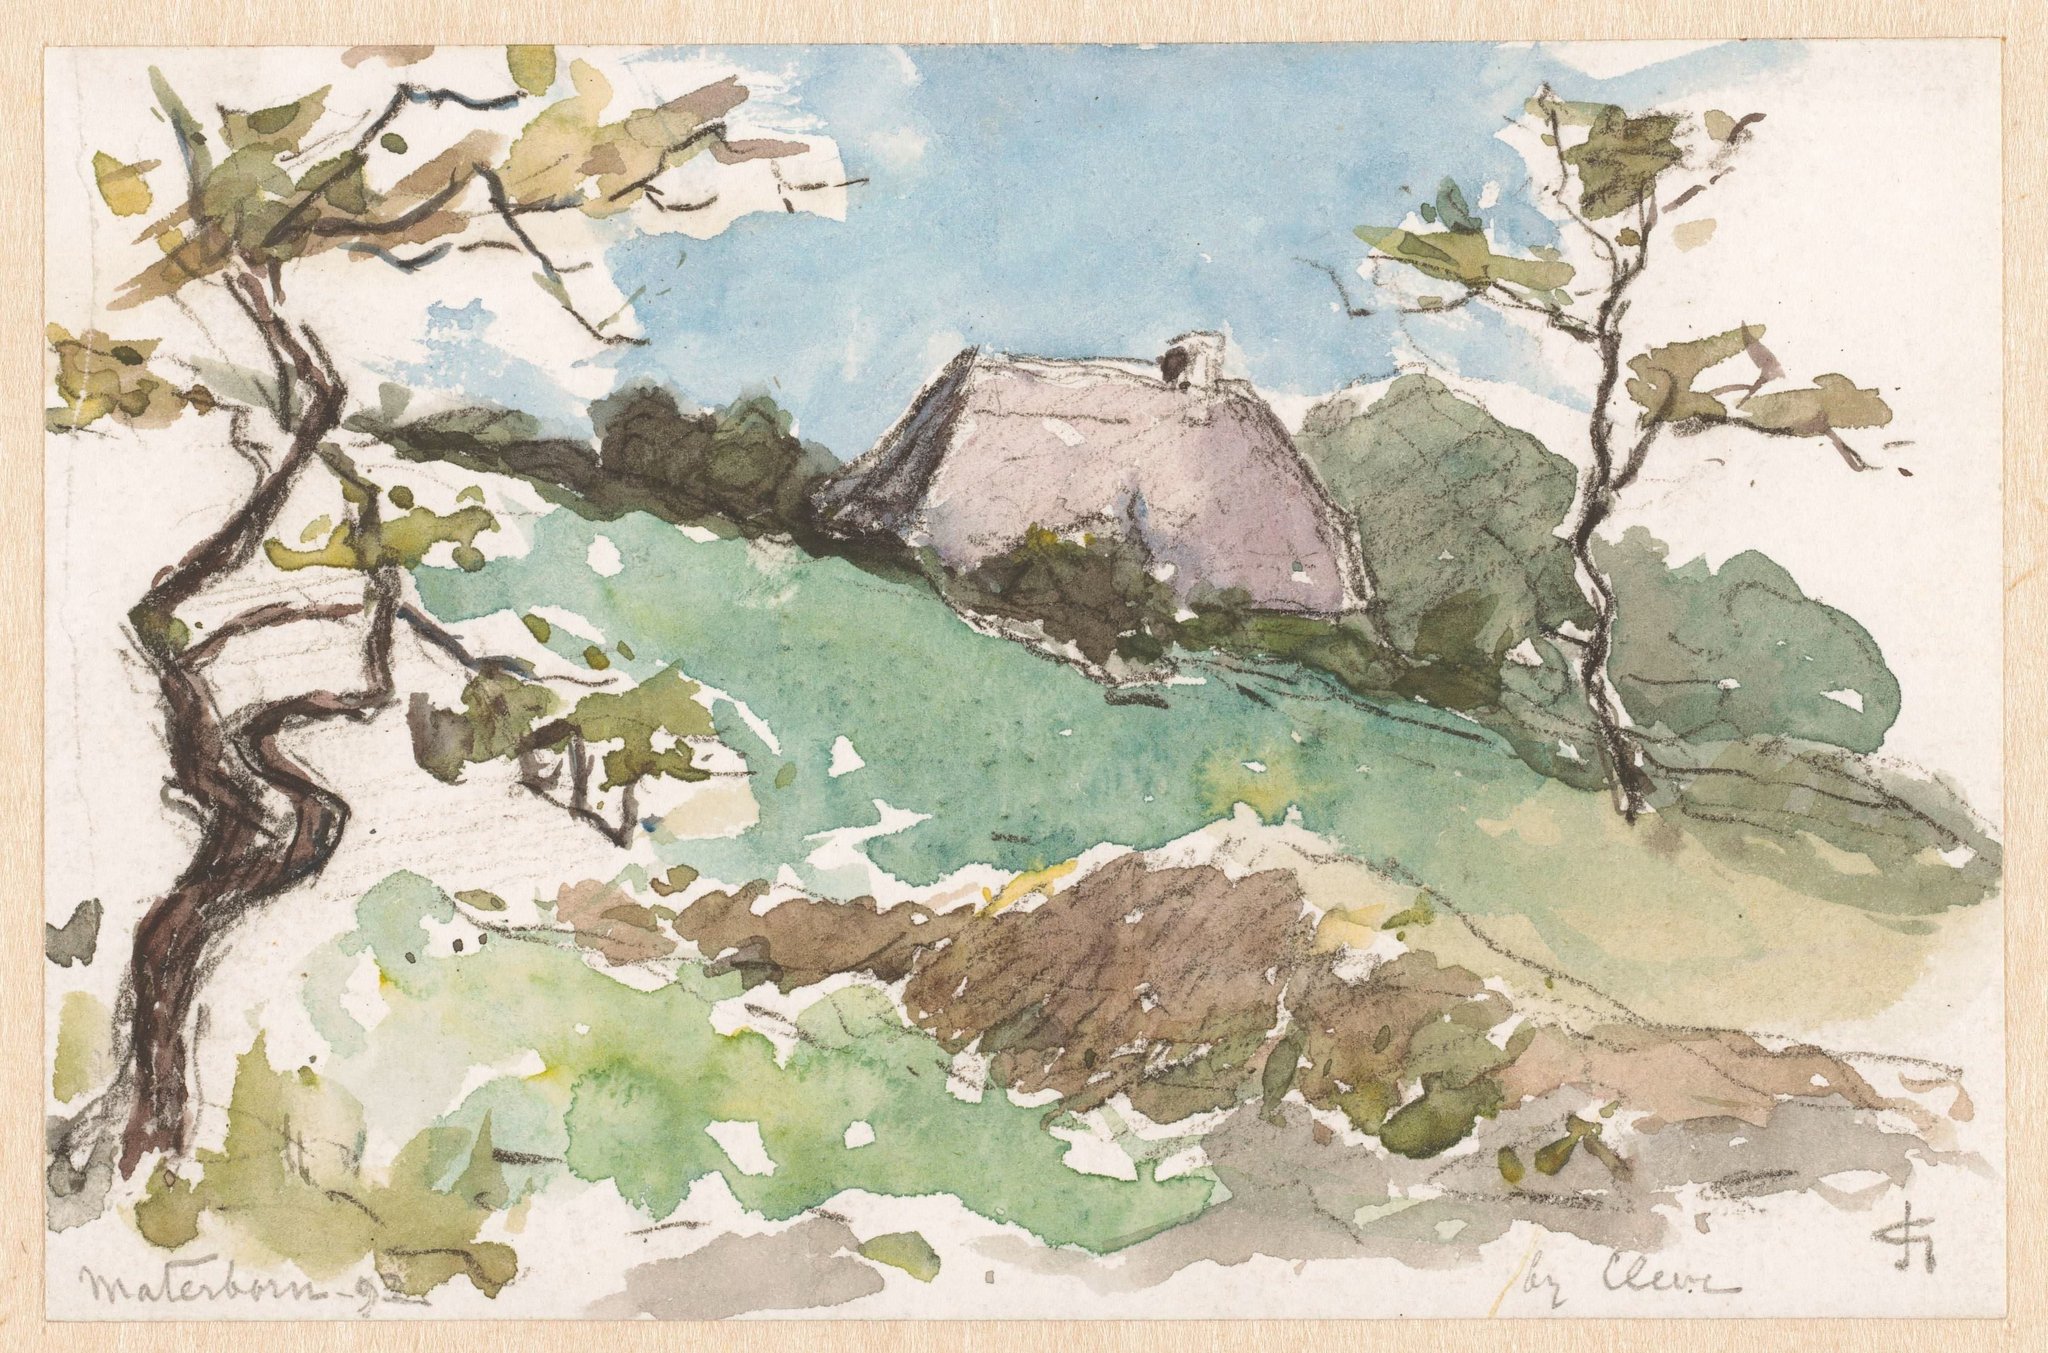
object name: watercolor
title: Landschap met boerderij te Materborn bij Kleve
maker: carel nicolaas storm van s-gravesande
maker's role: draughtsman, print maker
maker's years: 1841-1924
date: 1892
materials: chalk, paper, watercolor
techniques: brush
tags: farm (building), germany, cleves